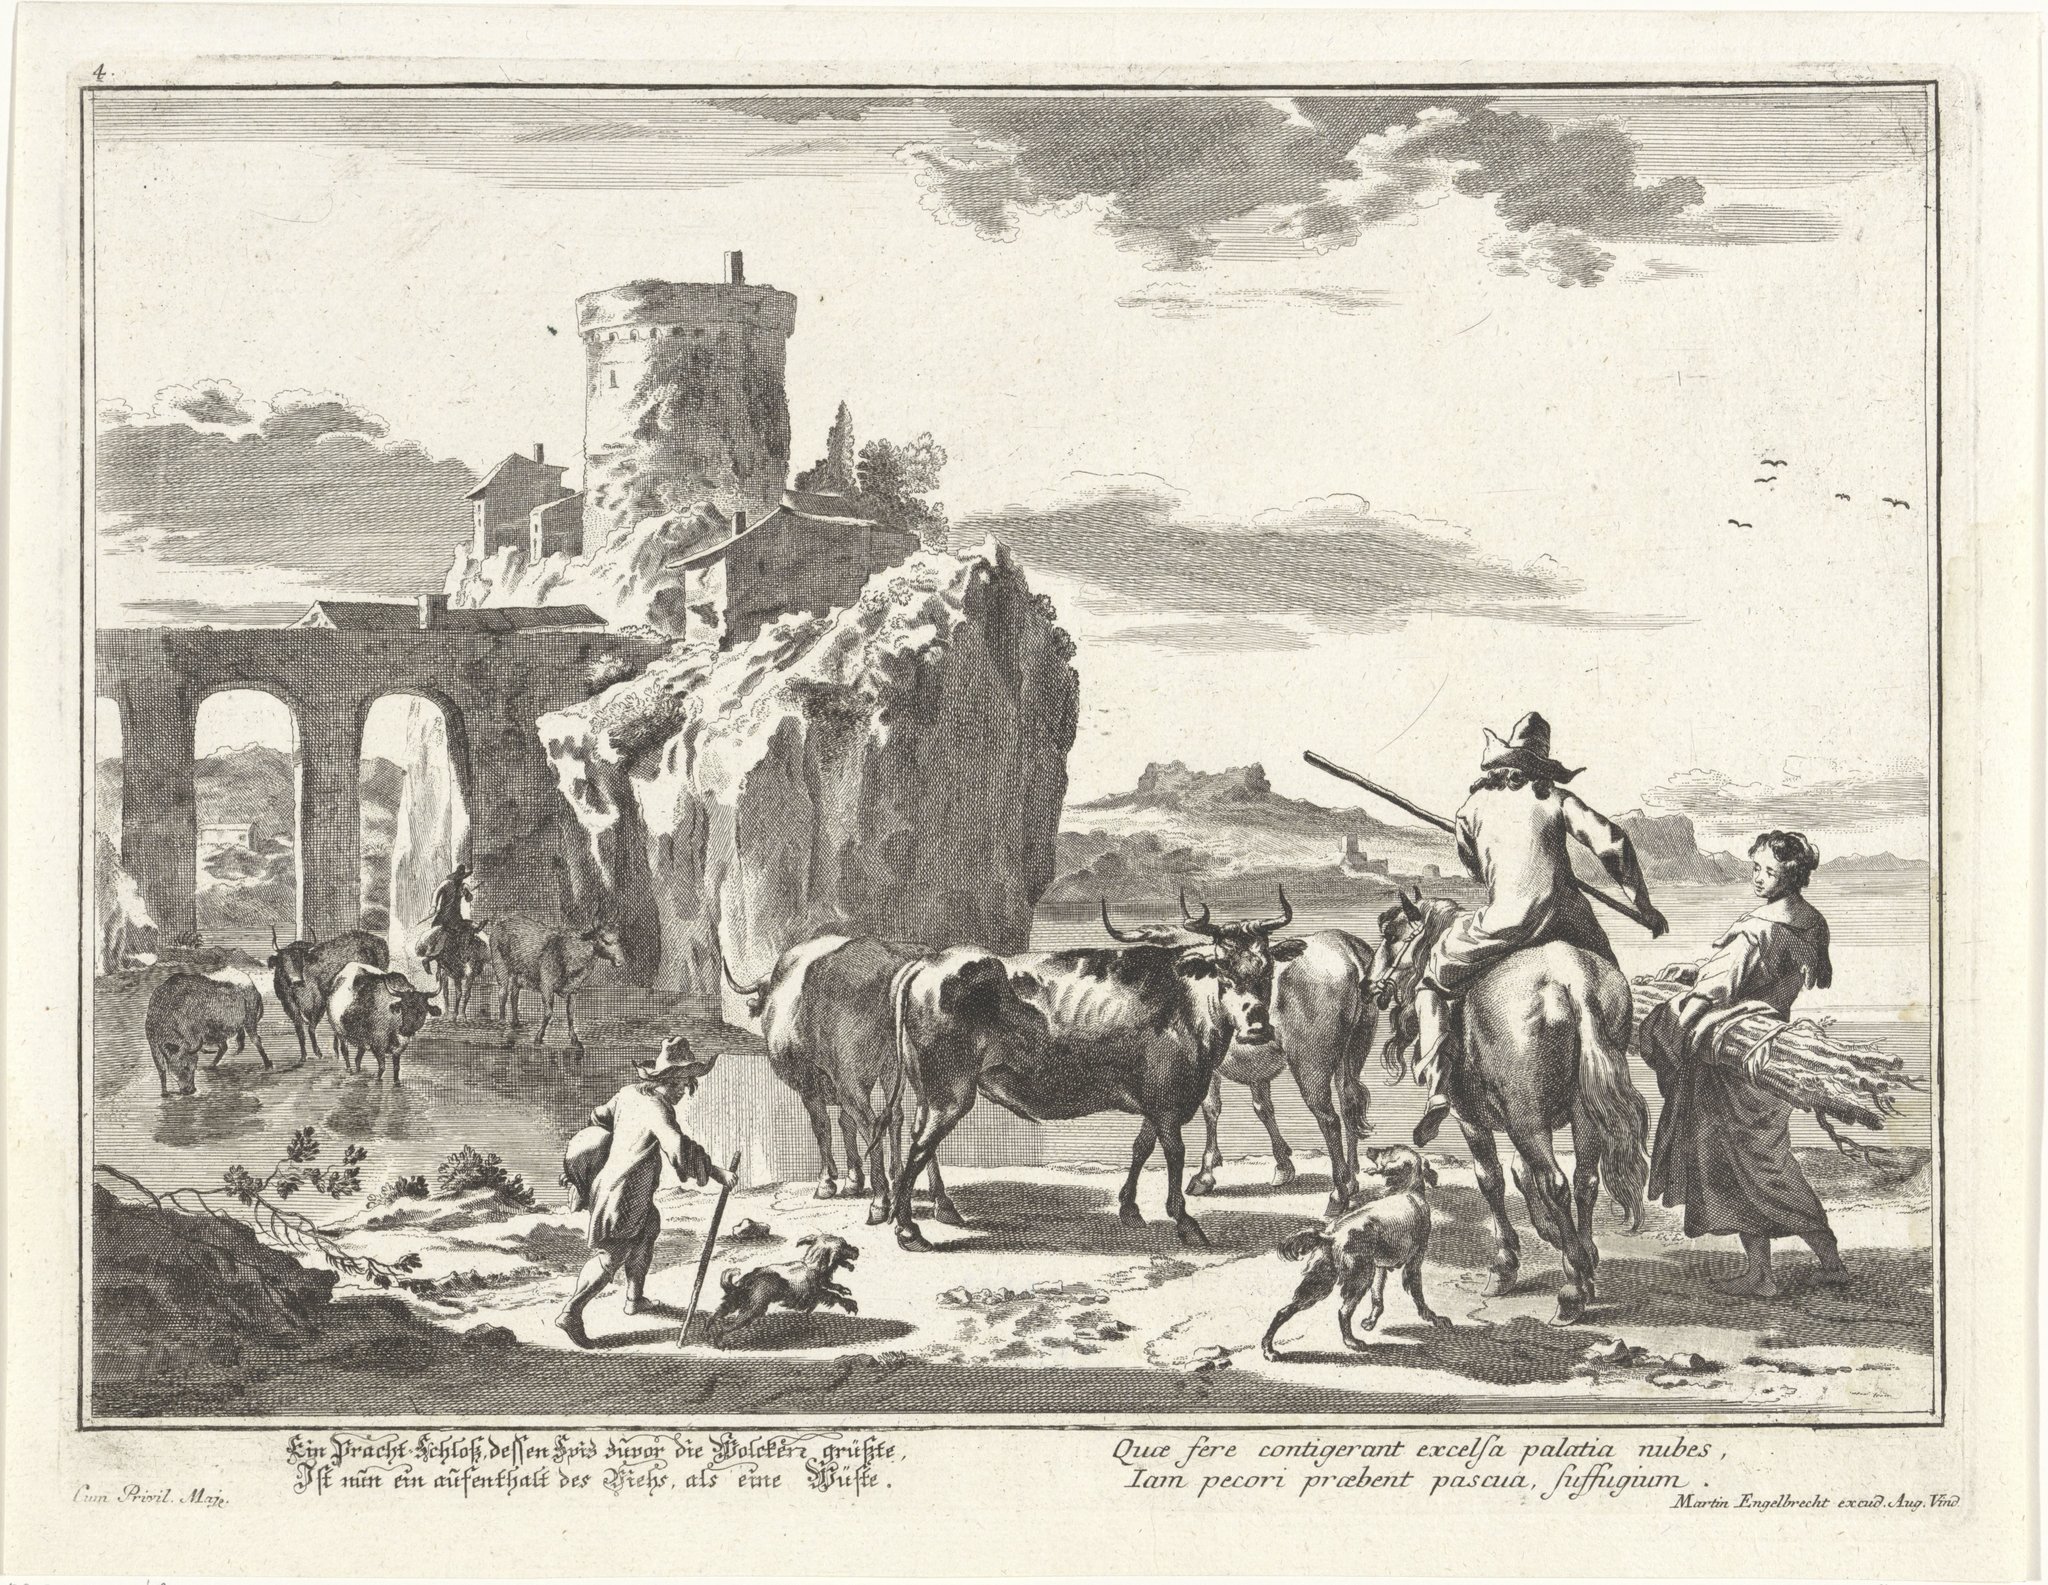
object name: print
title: Doorwaadbare plaats bij een aquaduct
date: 1699-1756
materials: paper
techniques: engraving, etching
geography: germany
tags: cow, herding, herdsman, herdswoman, shepherd, shepherdess, cowherd, etc., ford, landscape with bridge, viaduct or aqueduct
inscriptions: collector's mark: Lugt 2228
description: Herder te paard en een herderin voor een doorwaadbare plaats bij een aquaduct. In de voorde bevindt zich nog een herder te paard, met vier runderen.